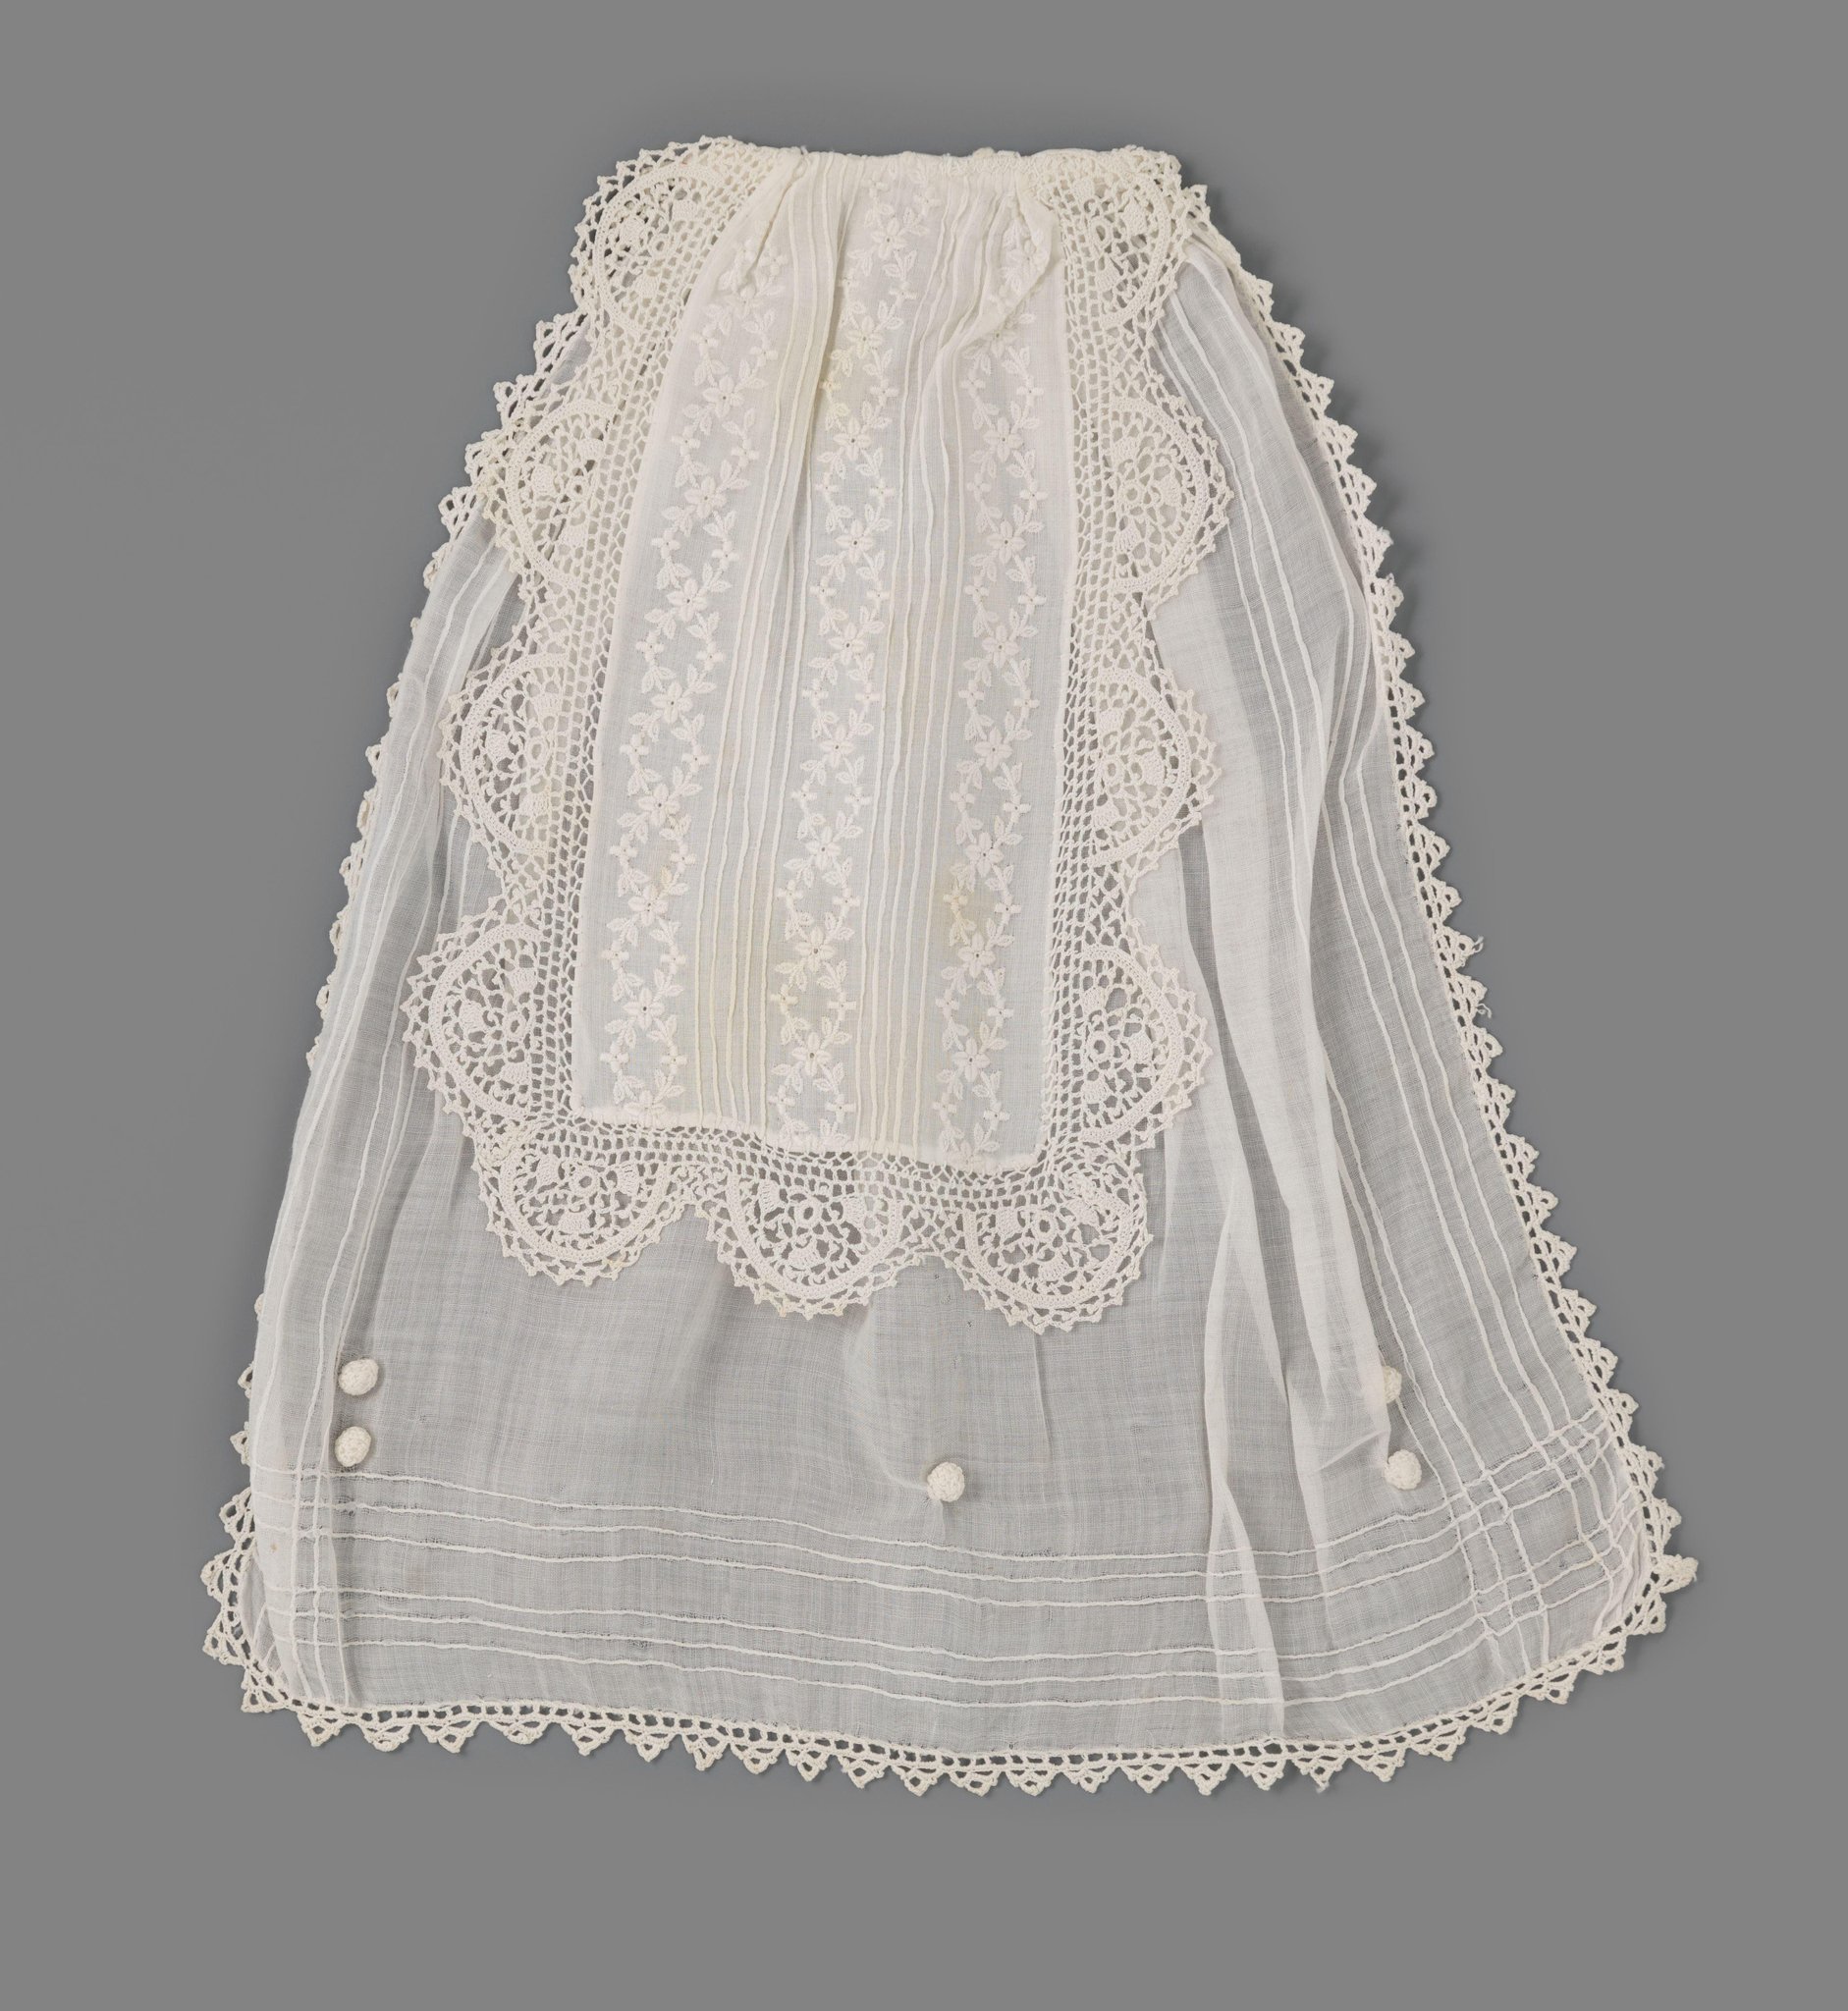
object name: jabot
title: Jabot van batist met witwerk en haakwerk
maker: Anonymous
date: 1910-1920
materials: cotton, linen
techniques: crochet, embroidered, embroidery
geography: netherlands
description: Jabot met twee slippen, waarvan de bovenste de kortste is, met witwerk versierd. Het patroon heeft op de bovenste slip driemaal een dubbele slinger tussen oprijgen en rondom vrij brede gehaakte schulpen. Op de onderste slip zijn vijf dikke knopen gezet en de rand is versierd met oprijgen en kleine gehaakte punten.